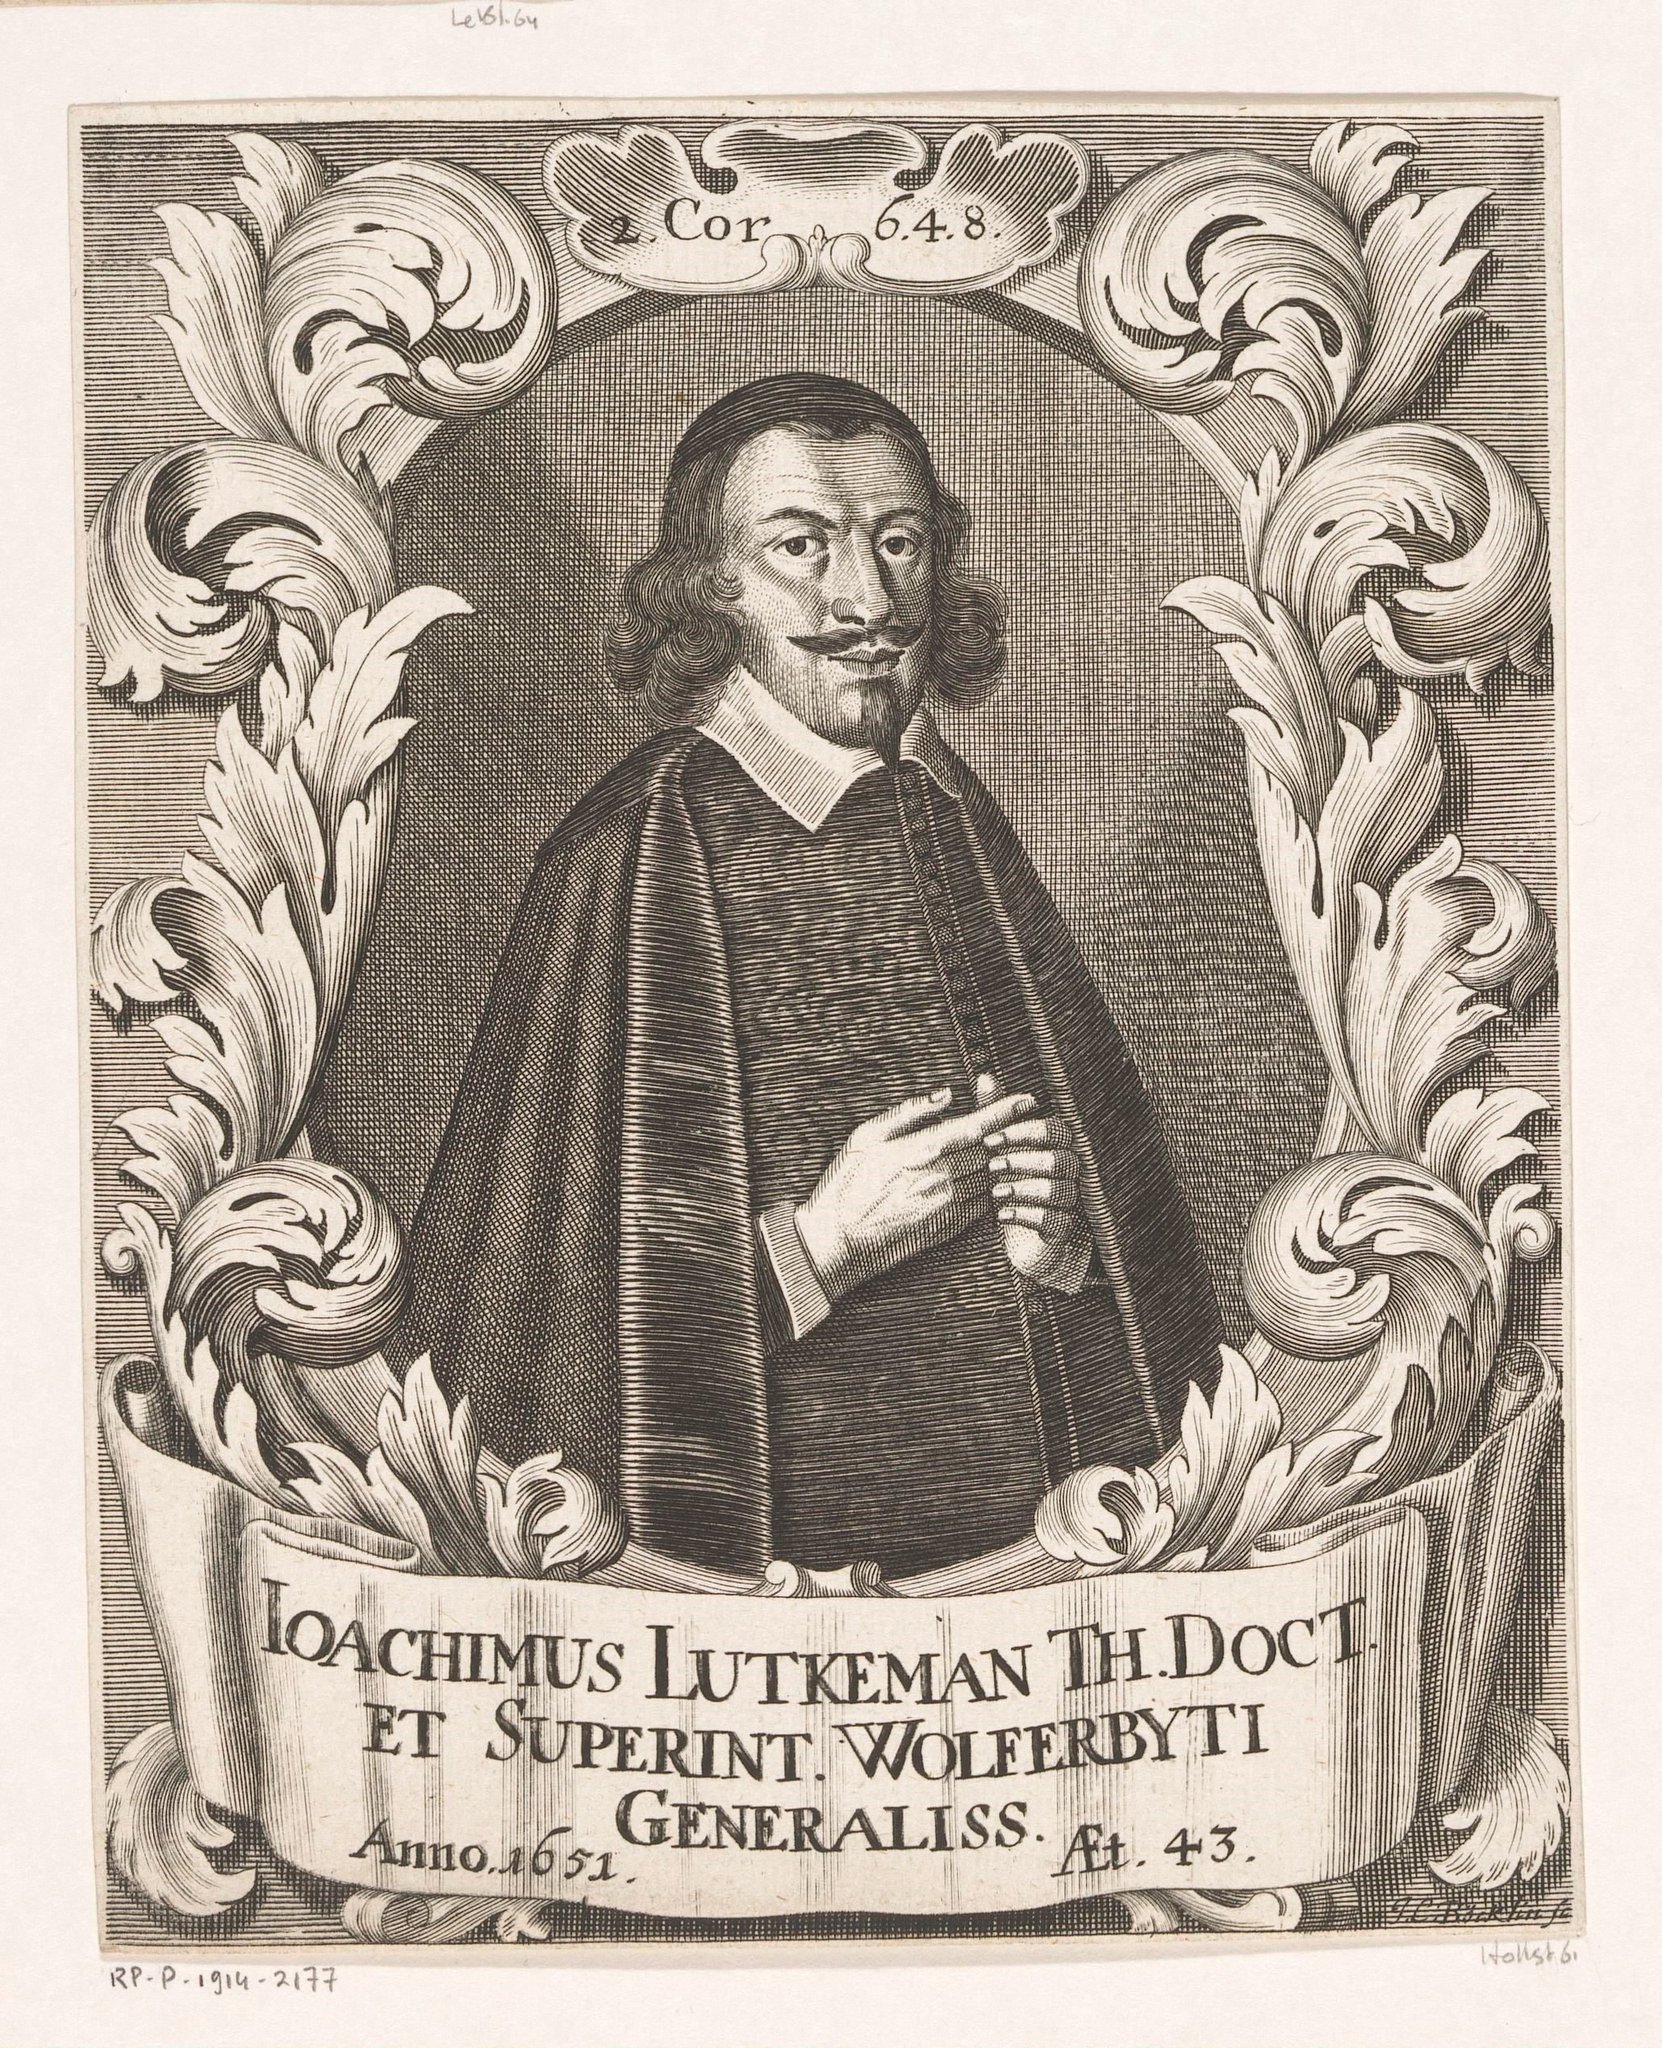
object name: print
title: Portret van Joachim Lütkemann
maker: johann christoph boecklin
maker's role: print maker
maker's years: 1657-1709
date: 1667-1709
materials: paper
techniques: engraving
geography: leipzig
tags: historical persons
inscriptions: collector's mark: Lugt 2228